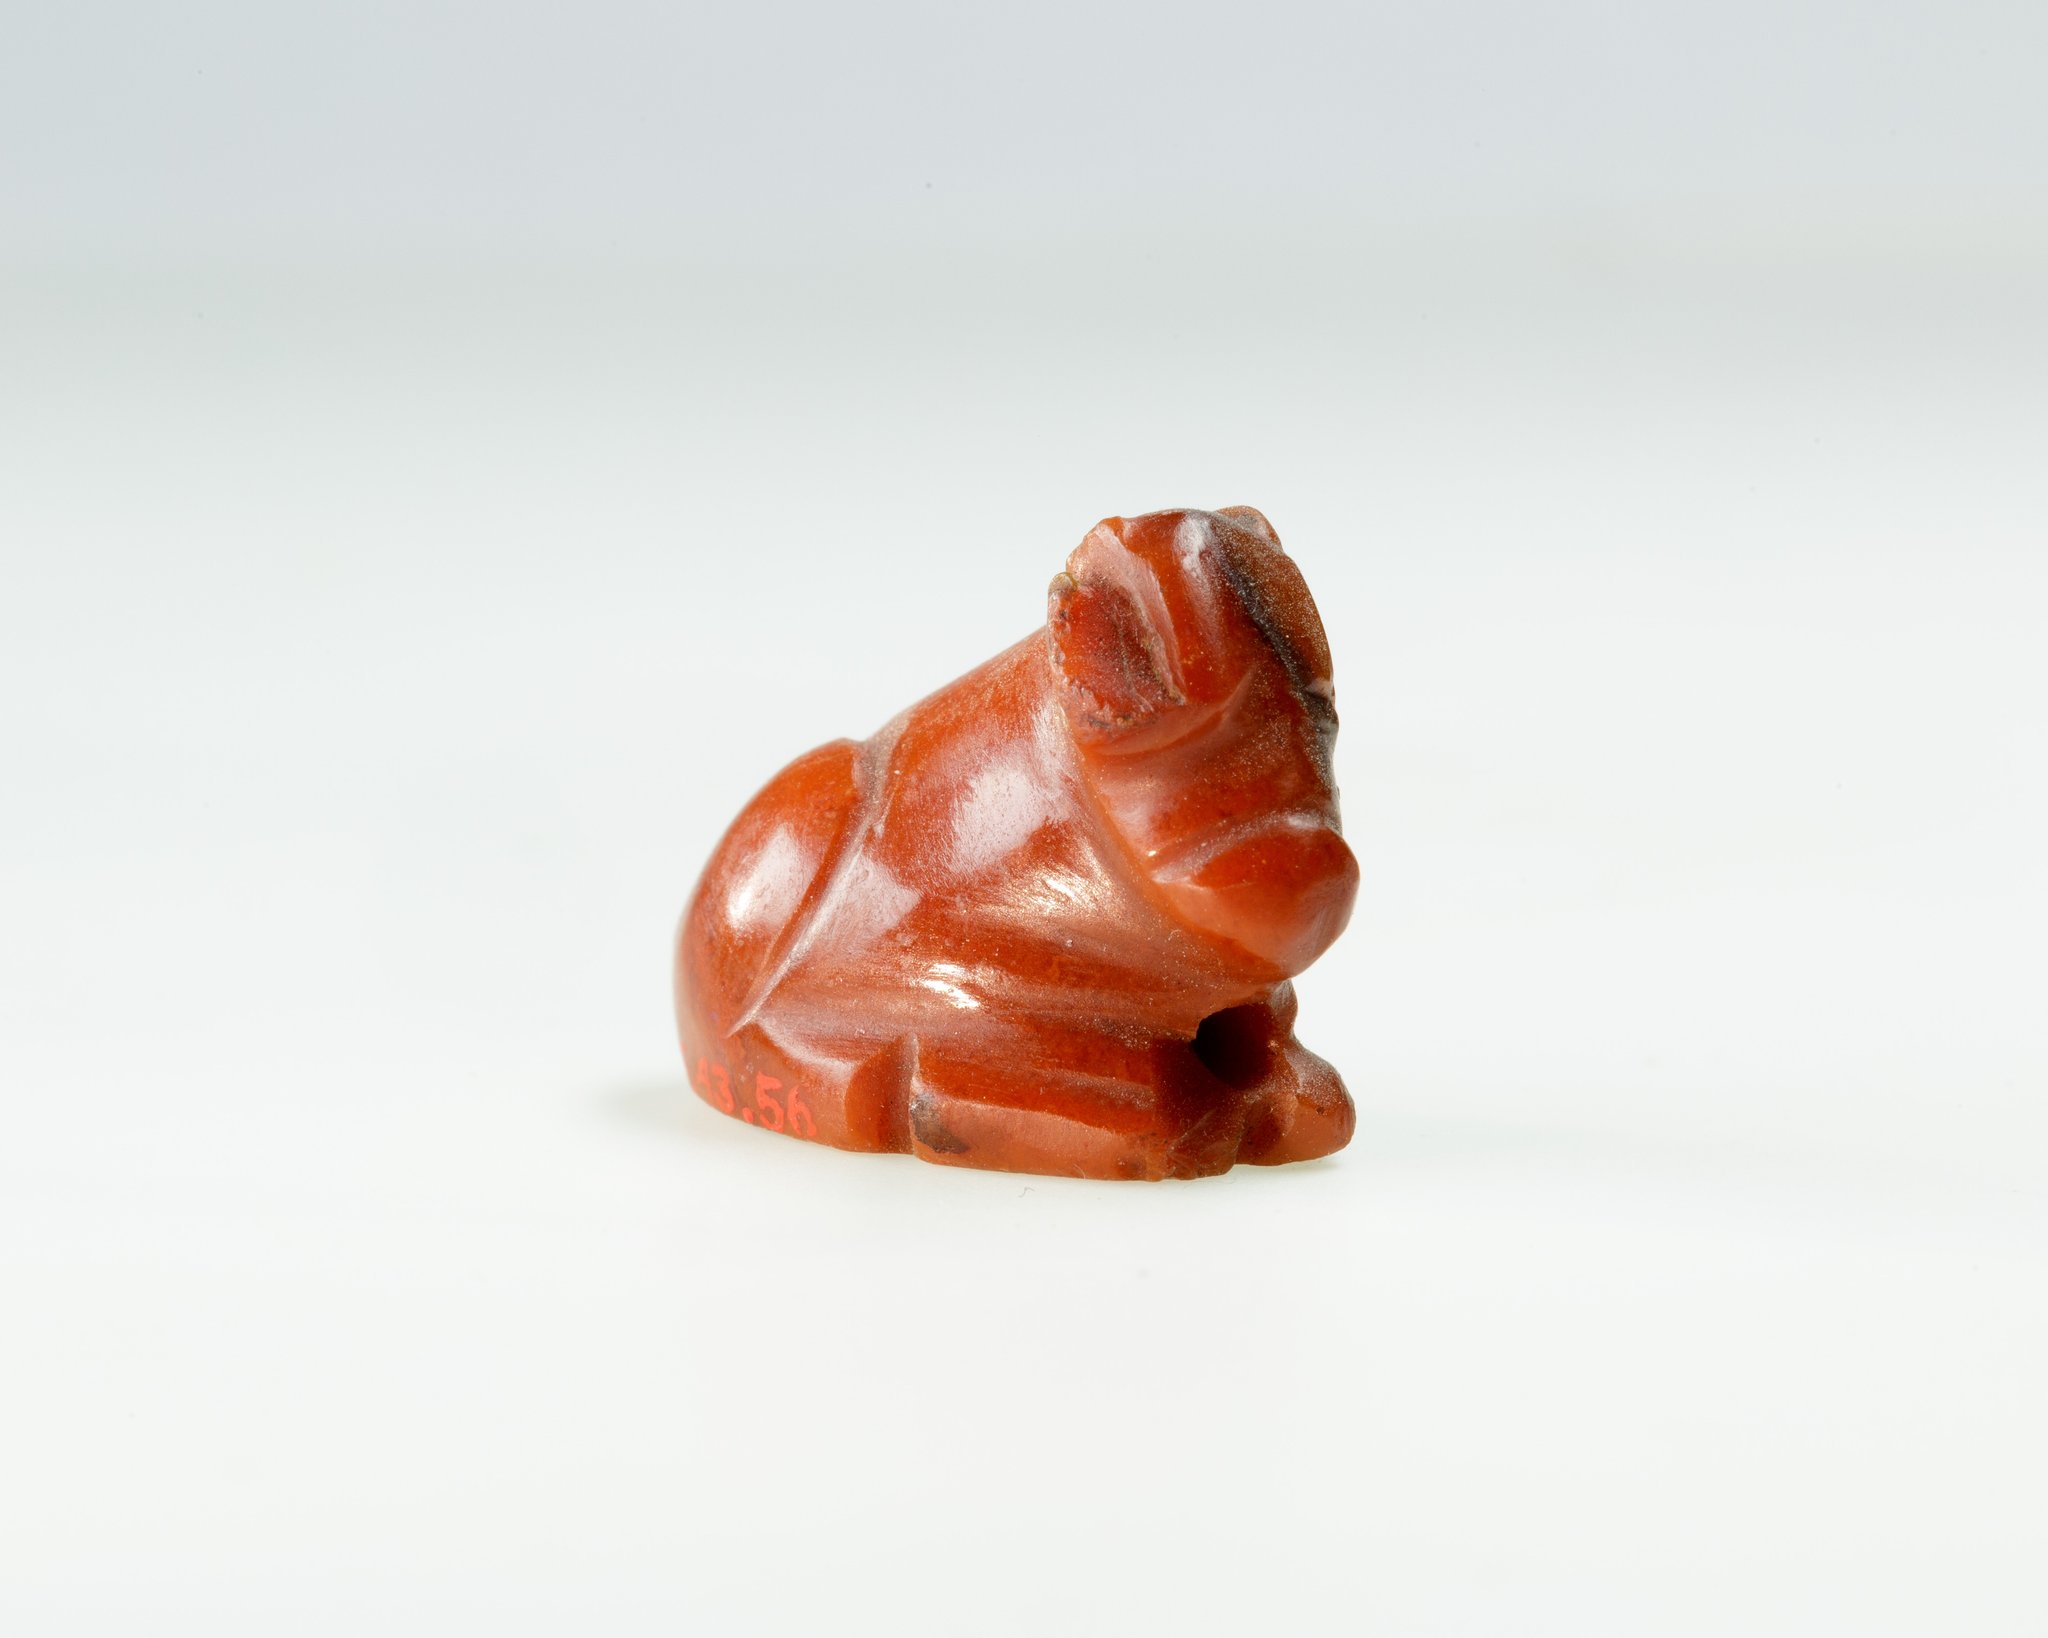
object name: amulet, bull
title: Bull Amulet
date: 1295-1185 BCE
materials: jasper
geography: egypt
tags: bulls